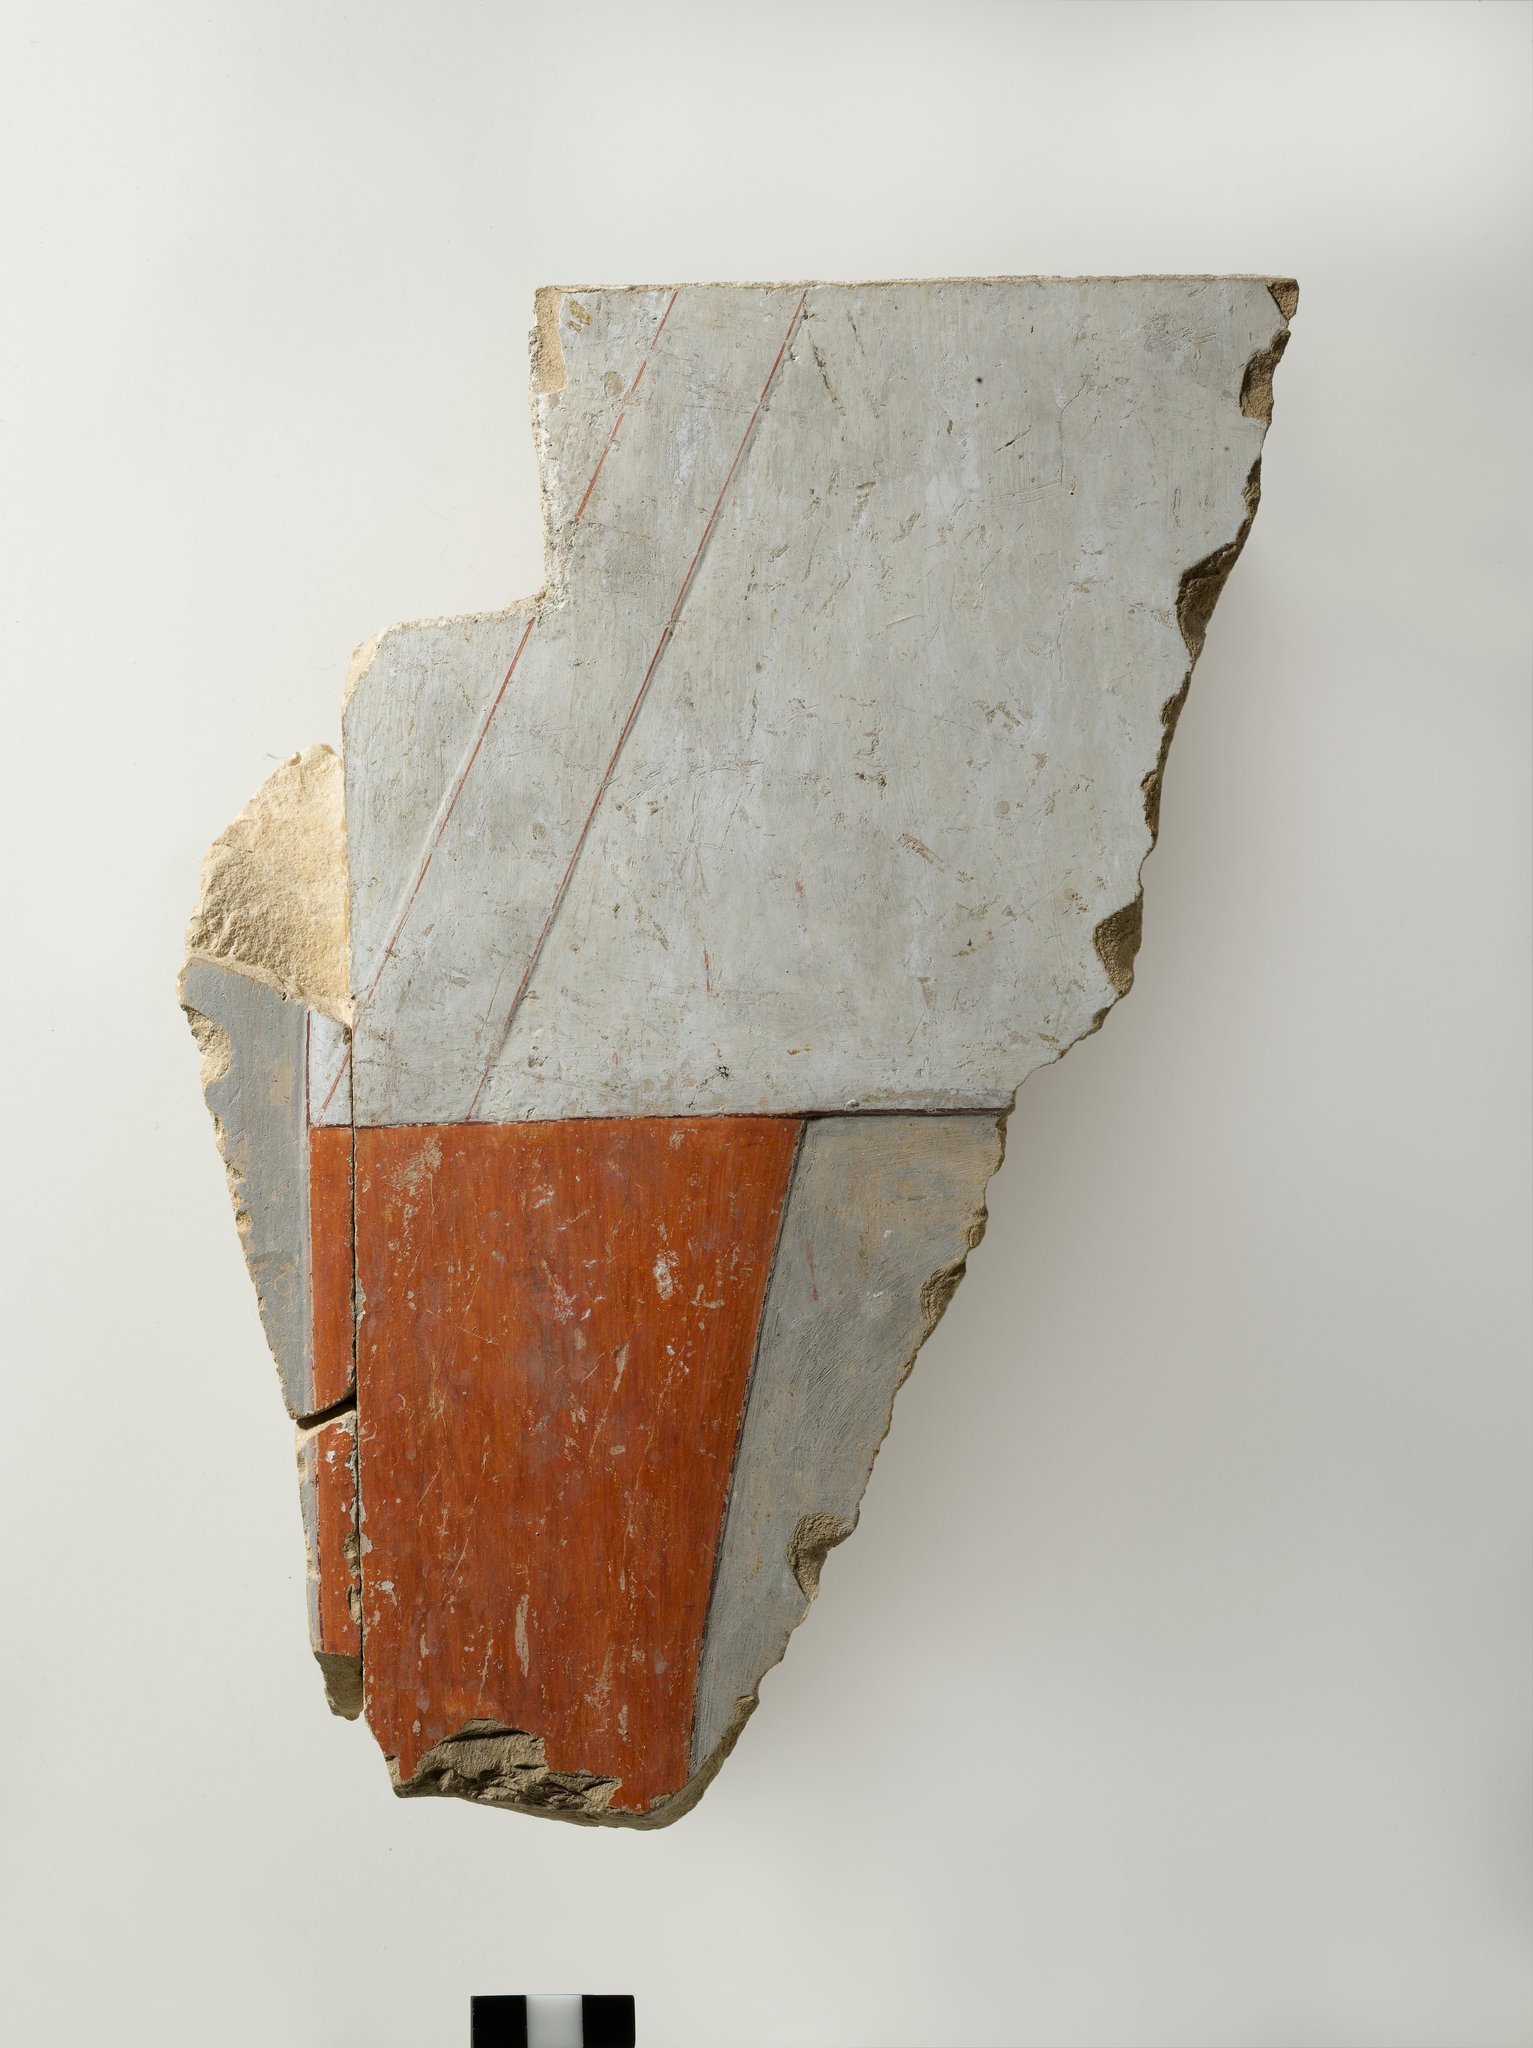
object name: relief fragment, tomb of meketre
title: Reliefs from the tomb of Meketre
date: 1981-1975 BCE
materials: limestone, paint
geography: egypt